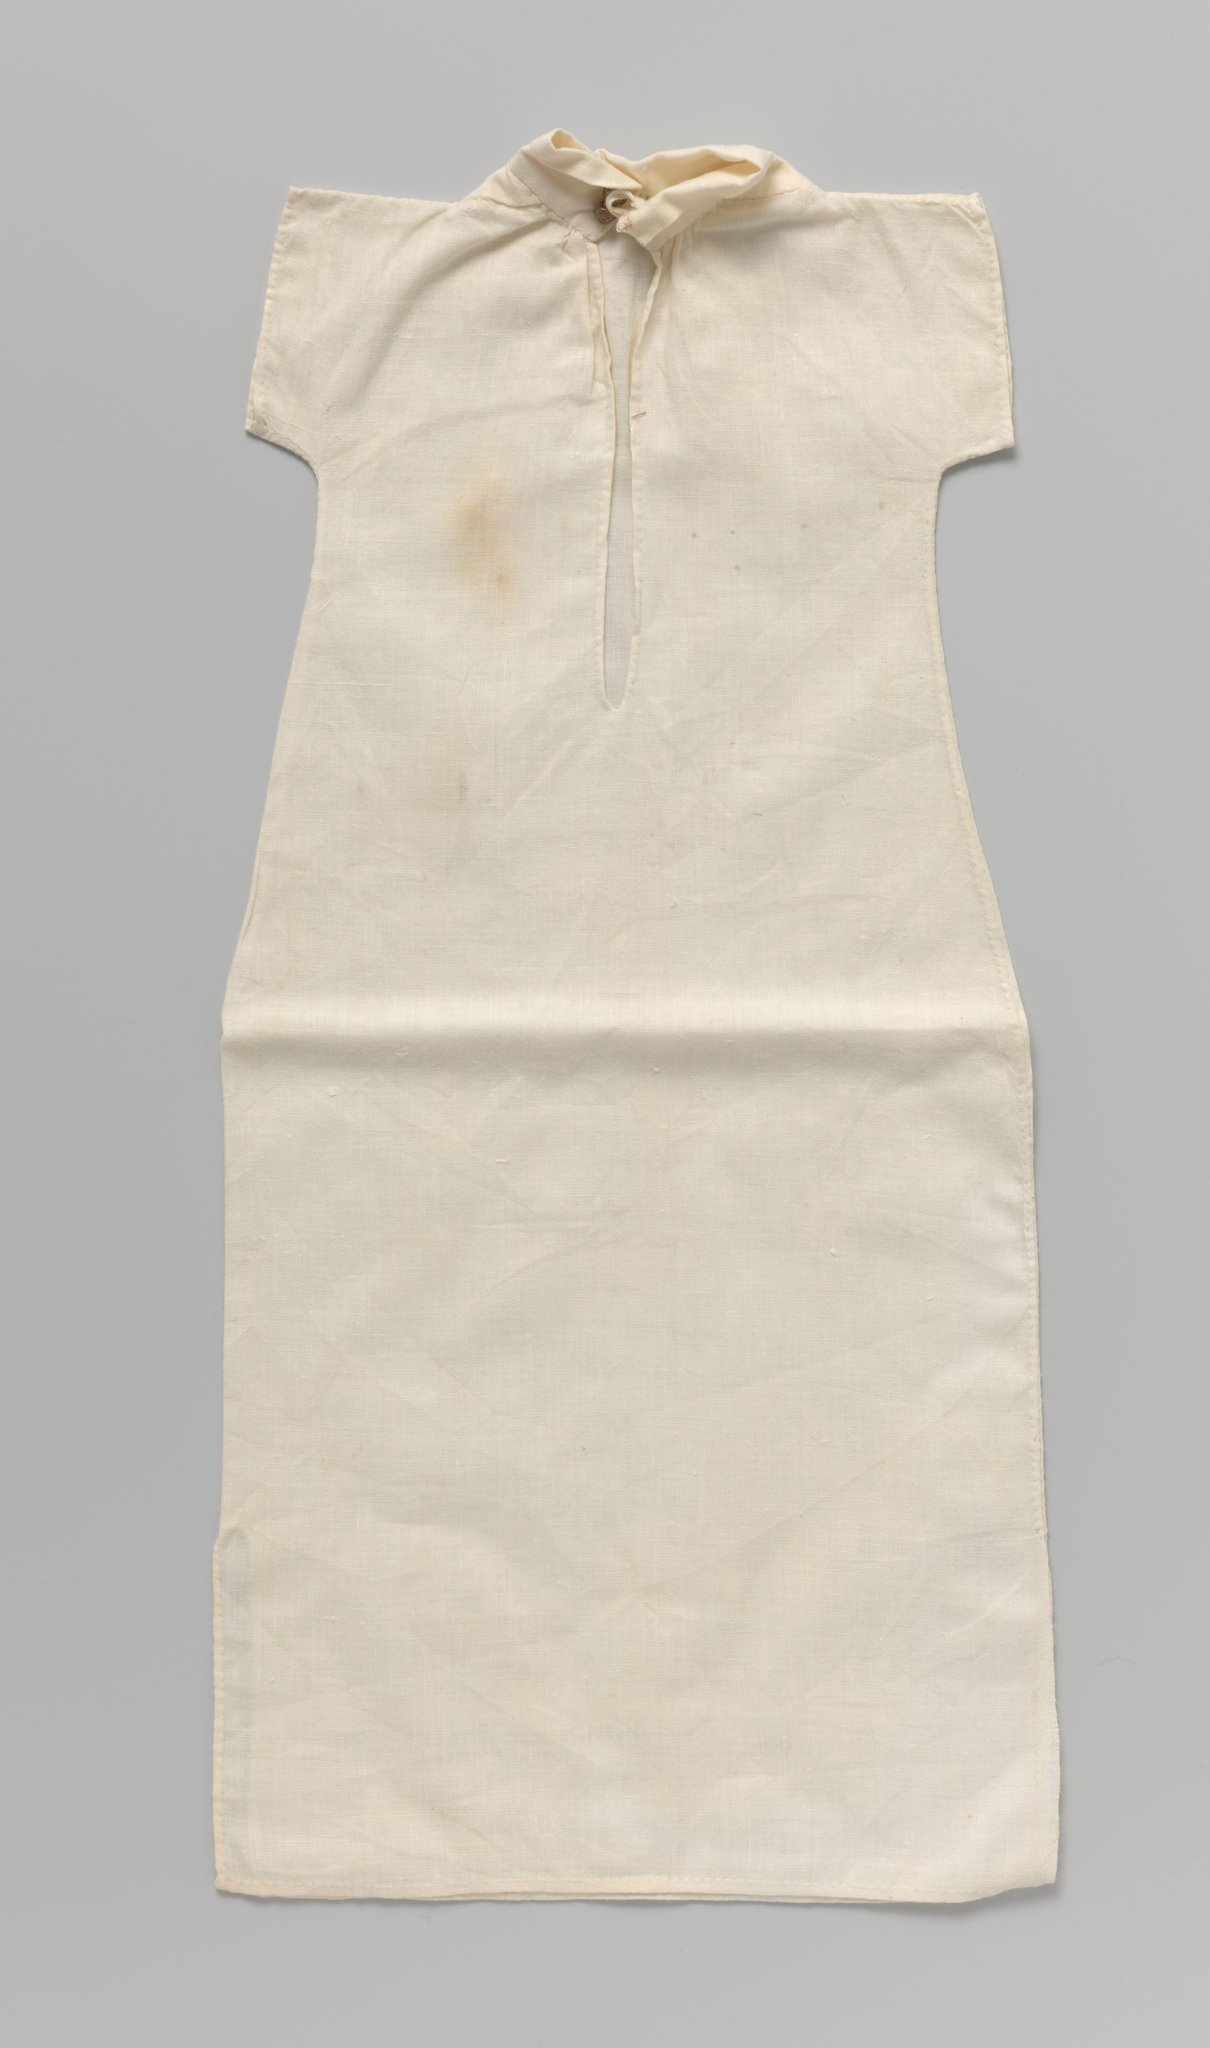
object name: streekdracht, streekkleding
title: Hemd of mouwhemd van katoen met twee koperen knopen aan het boord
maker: Anonymous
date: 1850-1900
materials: copper, cotton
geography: netherlands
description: Hemd of mouwhemd van katoen met twee koperen knopen aan het boord.